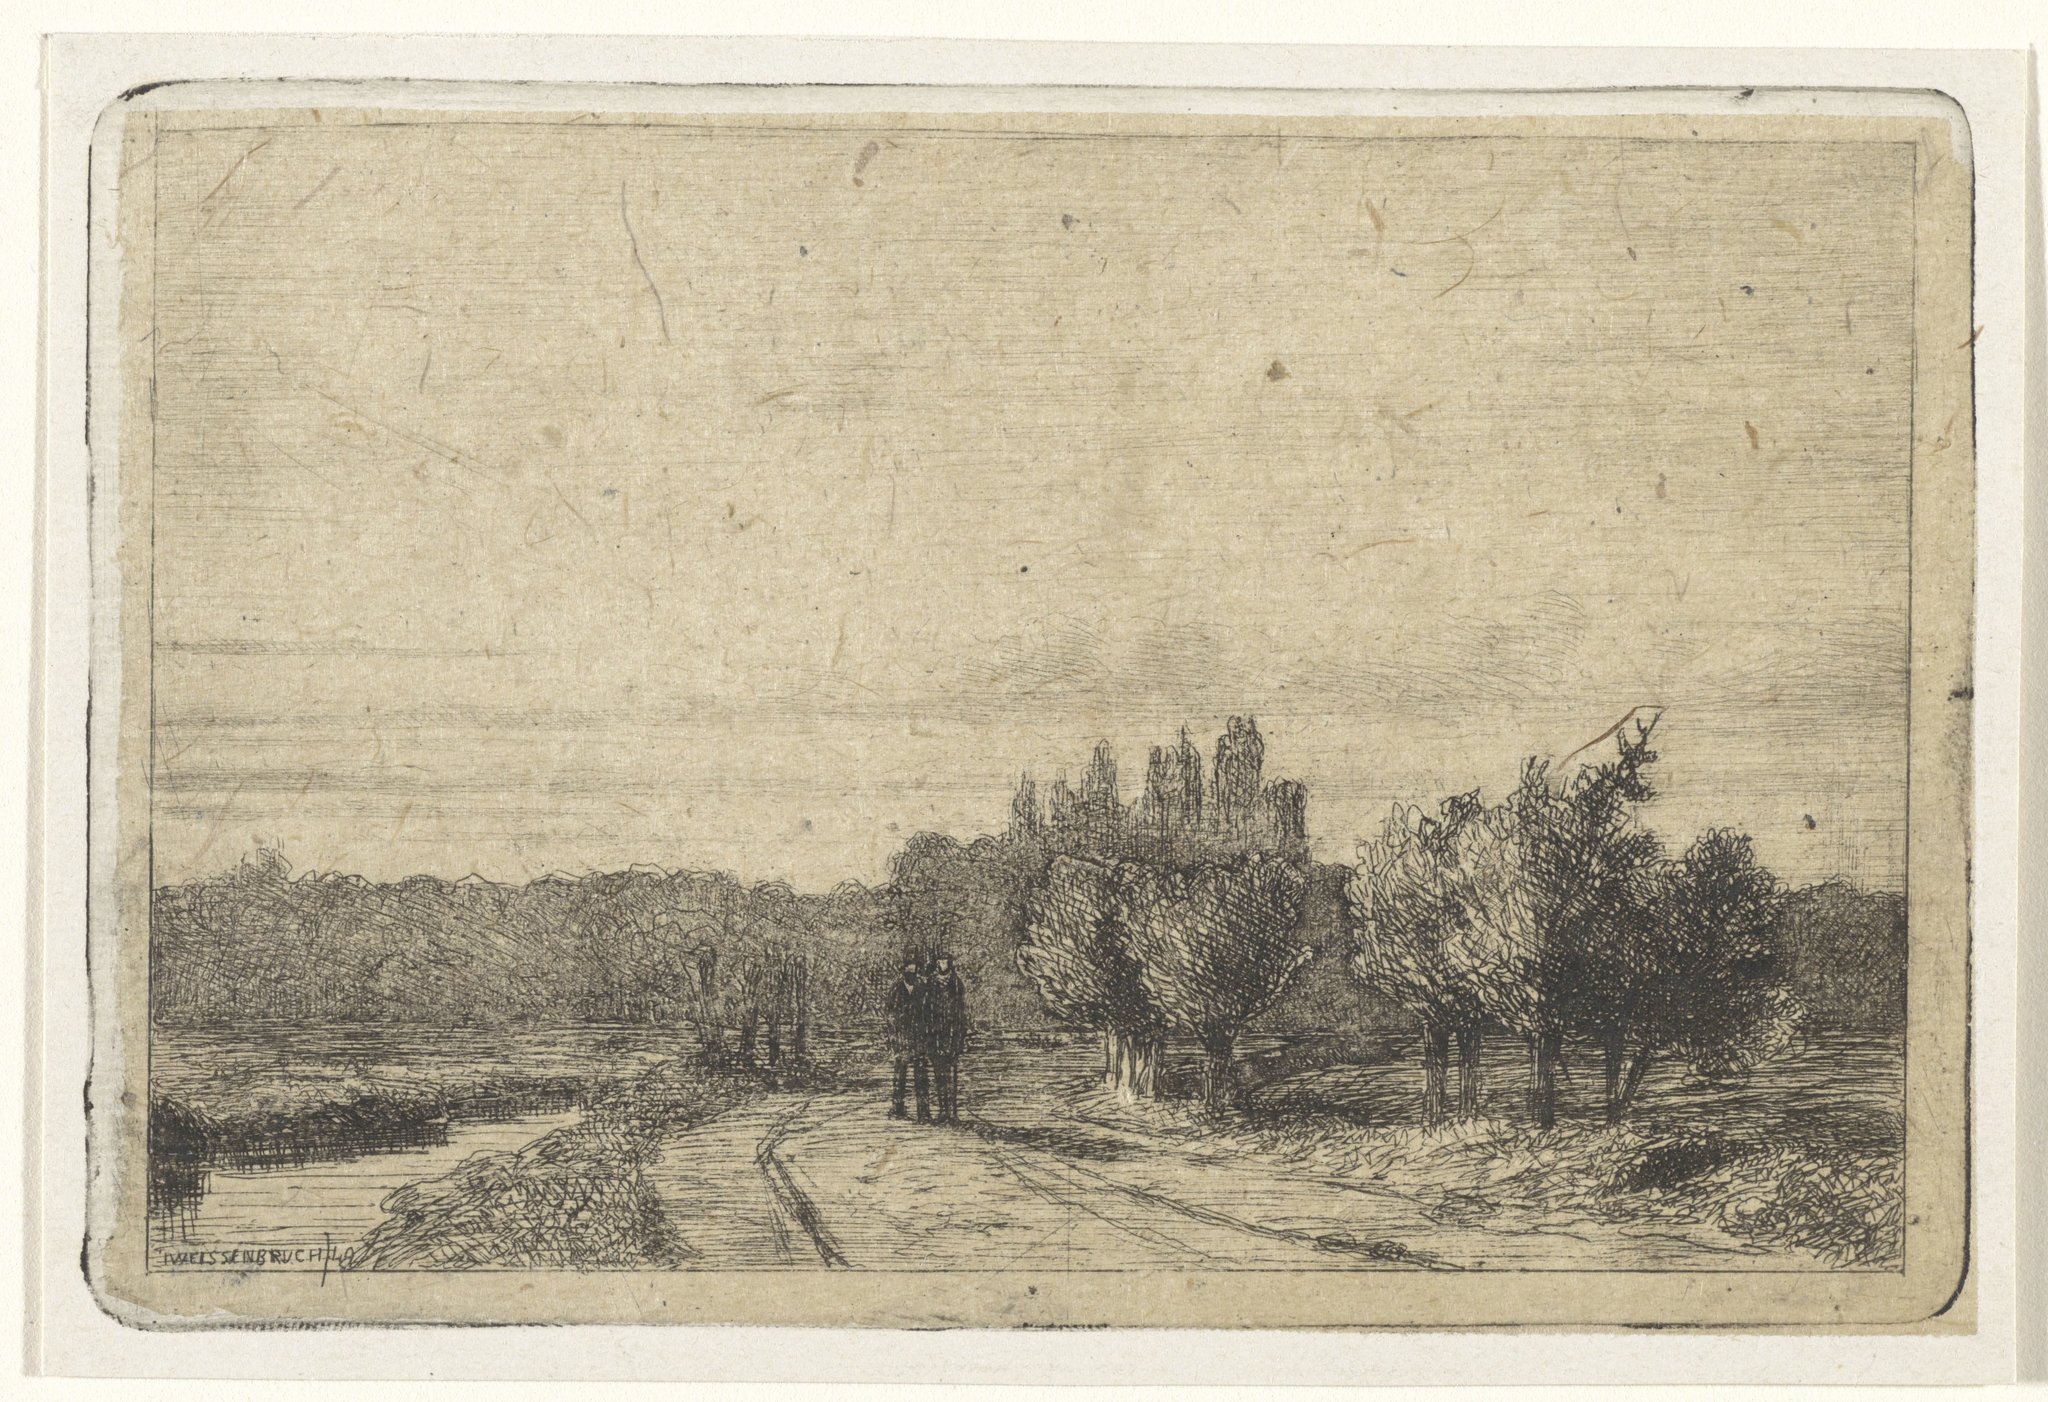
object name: print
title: Gezicht op de Schenkweg vanaf de Koepel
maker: jan weissenbruch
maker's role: painter, print maker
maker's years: 1822-1880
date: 1849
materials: paper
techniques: etching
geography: the hague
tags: trees, landscapes, adult man, road, path, brook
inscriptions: collector's mark: Lugt 2228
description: Twee mannen, mogelijk leden van de Haagsche Etsclub, staan op de Haagse Schenkweg. Links stroomt een beek en rechts zijn enkele bomen te zien.